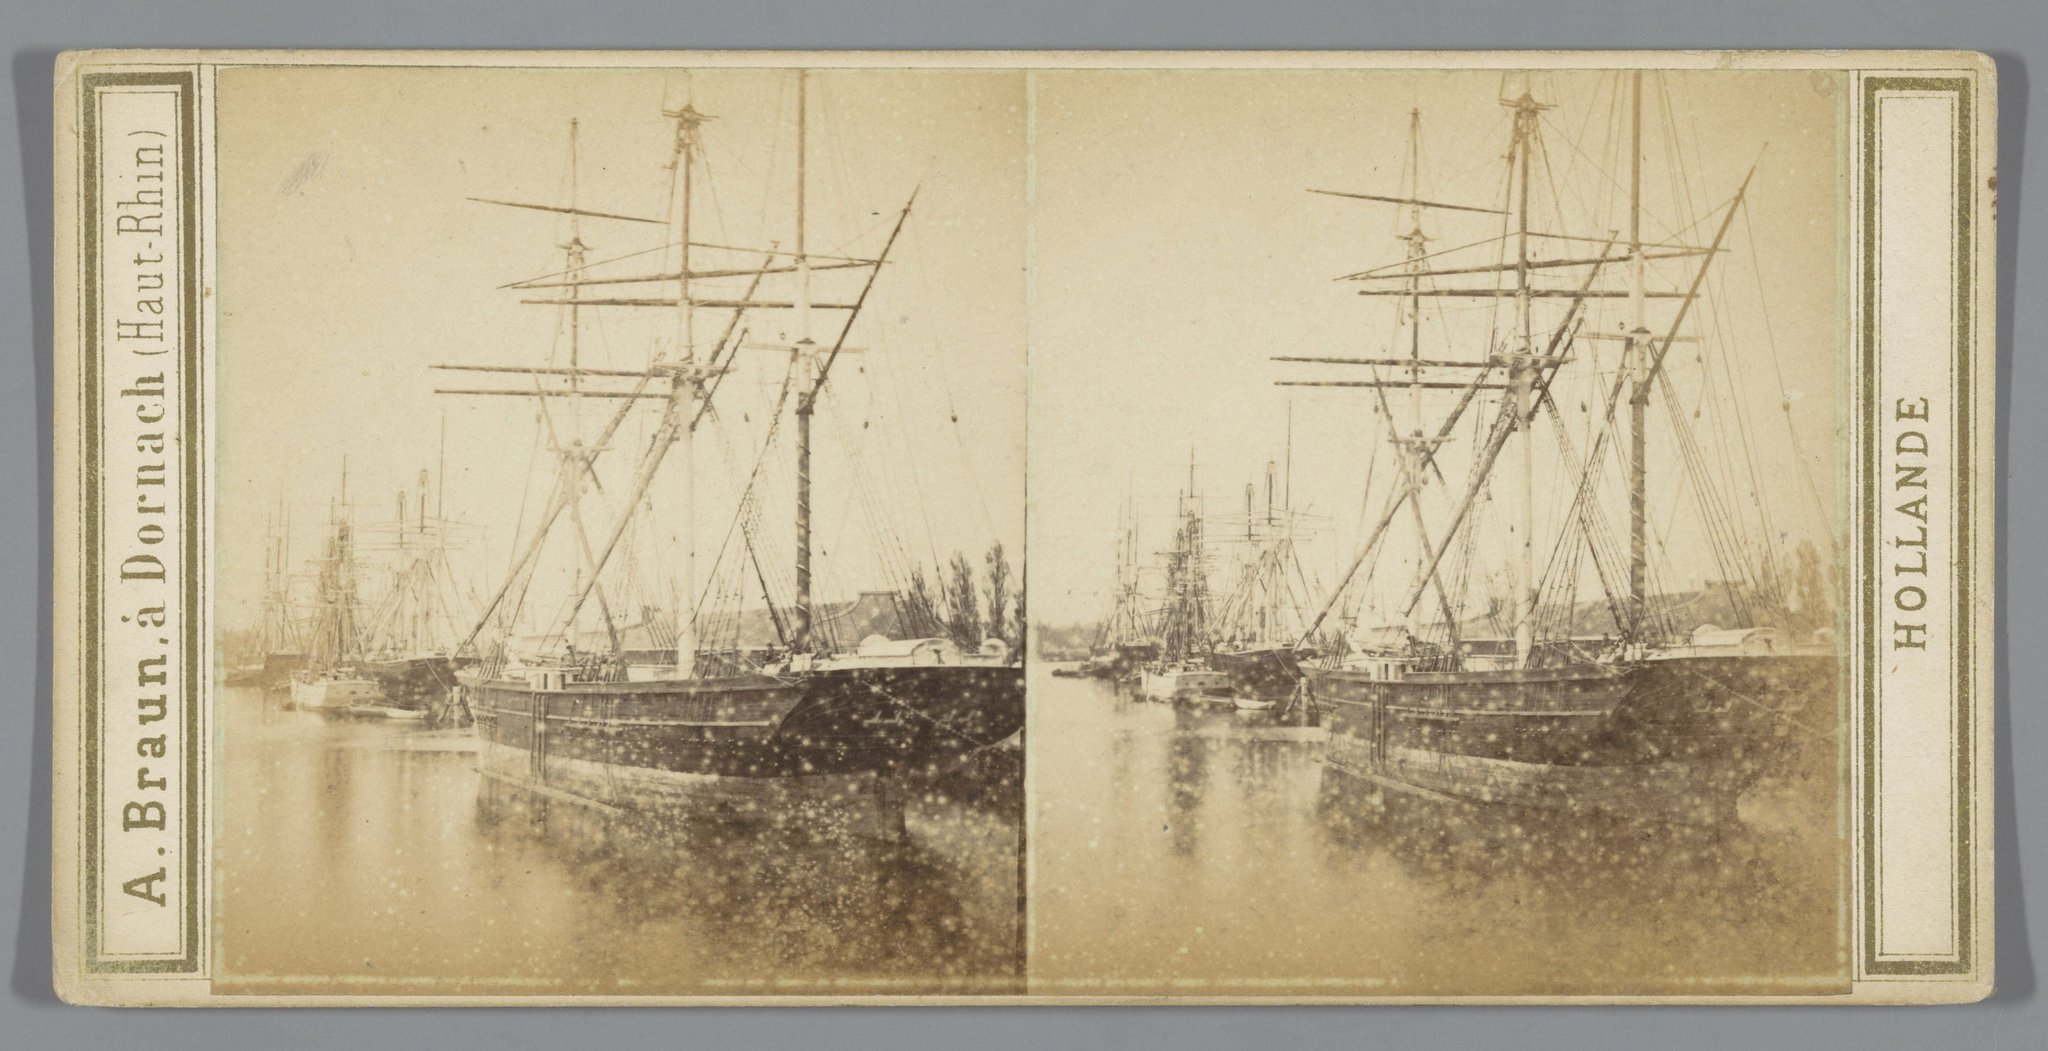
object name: stereograph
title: Hollande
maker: gaston braun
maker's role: fotograaf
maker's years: 1845-1928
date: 1864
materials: cardboard, paper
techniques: albumen print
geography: oosterdok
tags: ships (in general) - cc - more than one ship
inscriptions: number: ‘No. 3973.’